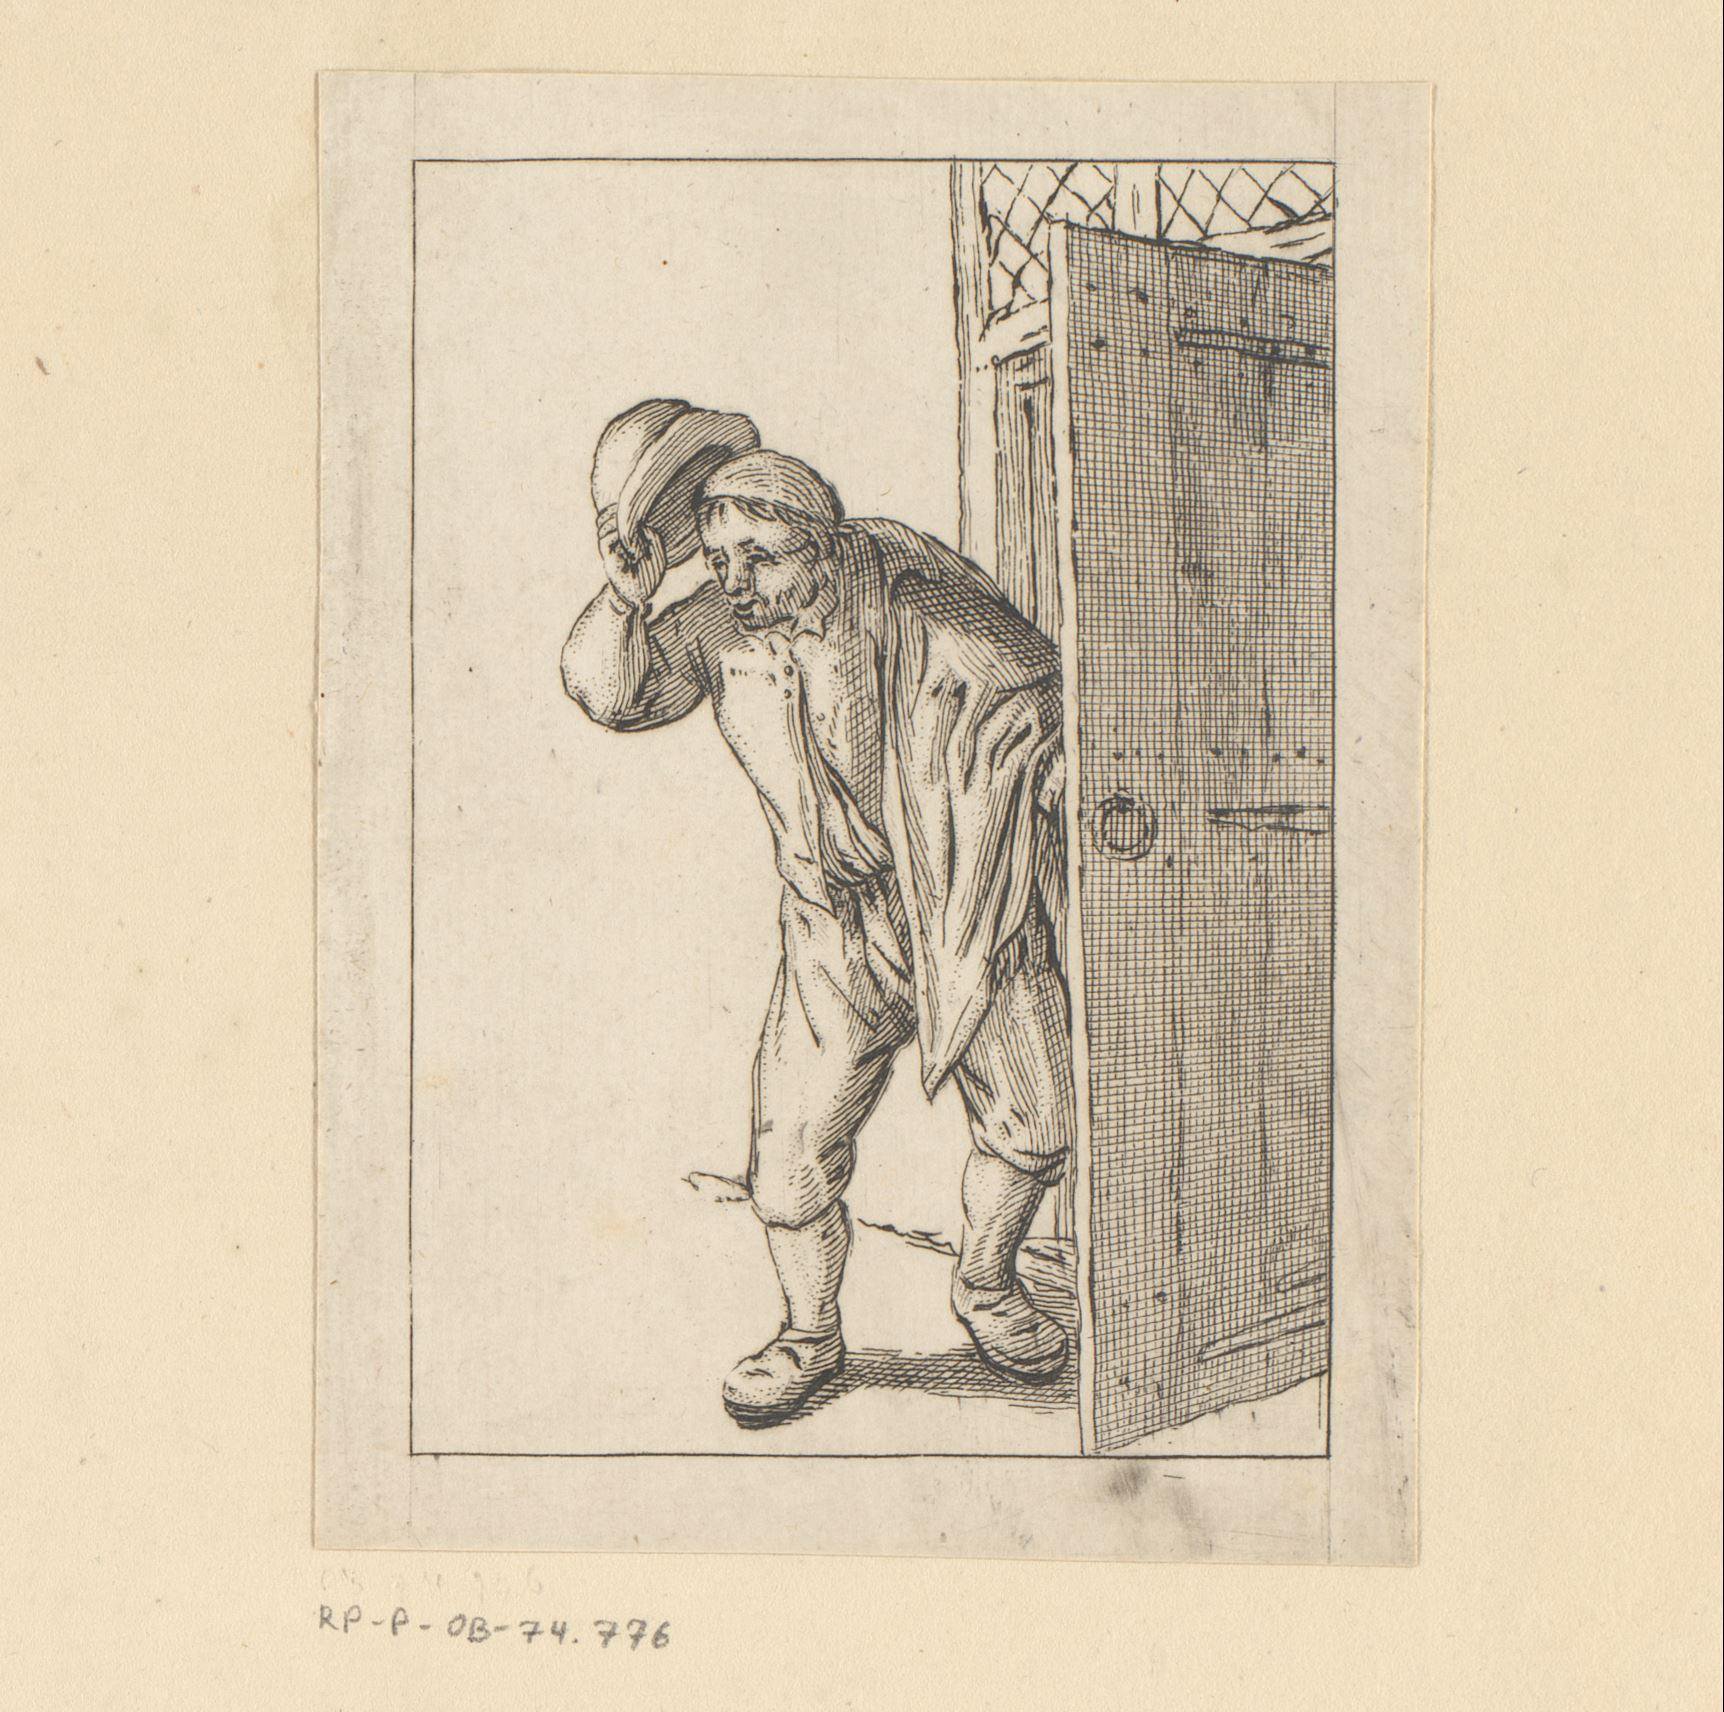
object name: print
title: Man die door deur komt en hoed afneemt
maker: Anonymous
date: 1700-1730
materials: paper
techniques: etching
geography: france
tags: adult man, opening the door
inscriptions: collector's mark: Lugt 240